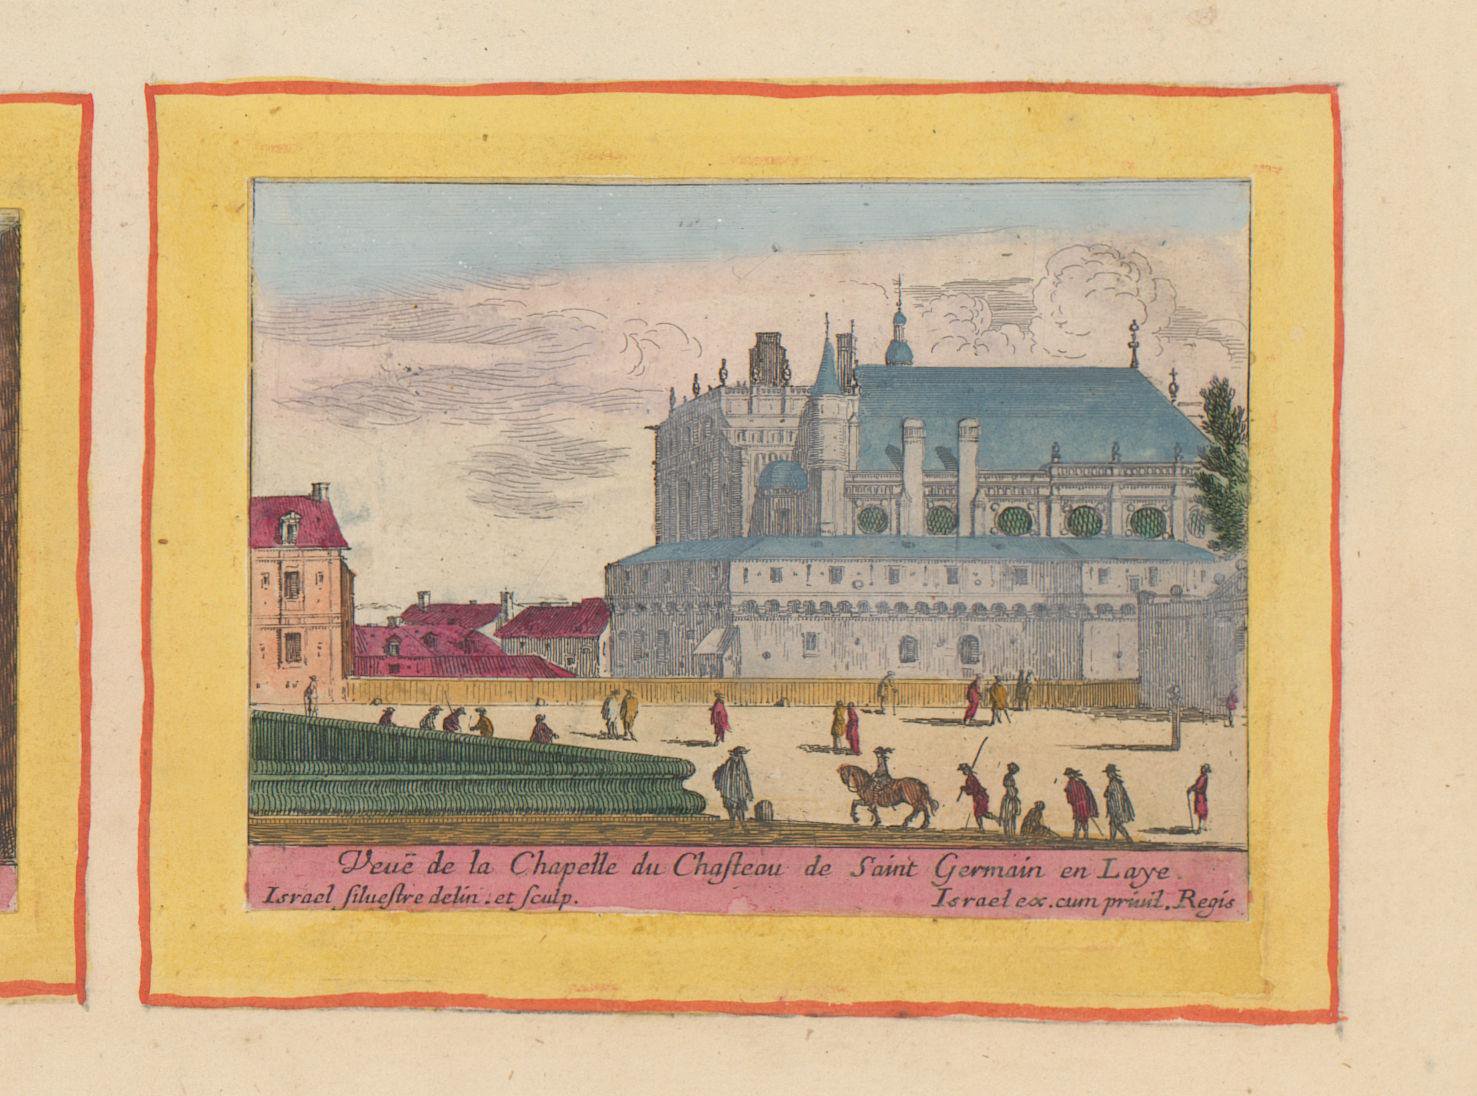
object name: print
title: Veuë de la Chapelle du Chasteau de Saint Germain en Laye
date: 1631-1661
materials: paper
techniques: etching, hand coloring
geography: paris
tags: castle, church (exterior)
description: Gezicht op de kapel van het Château de Saint-Germain-en-Laye. Prent maakt deel uit van een album.